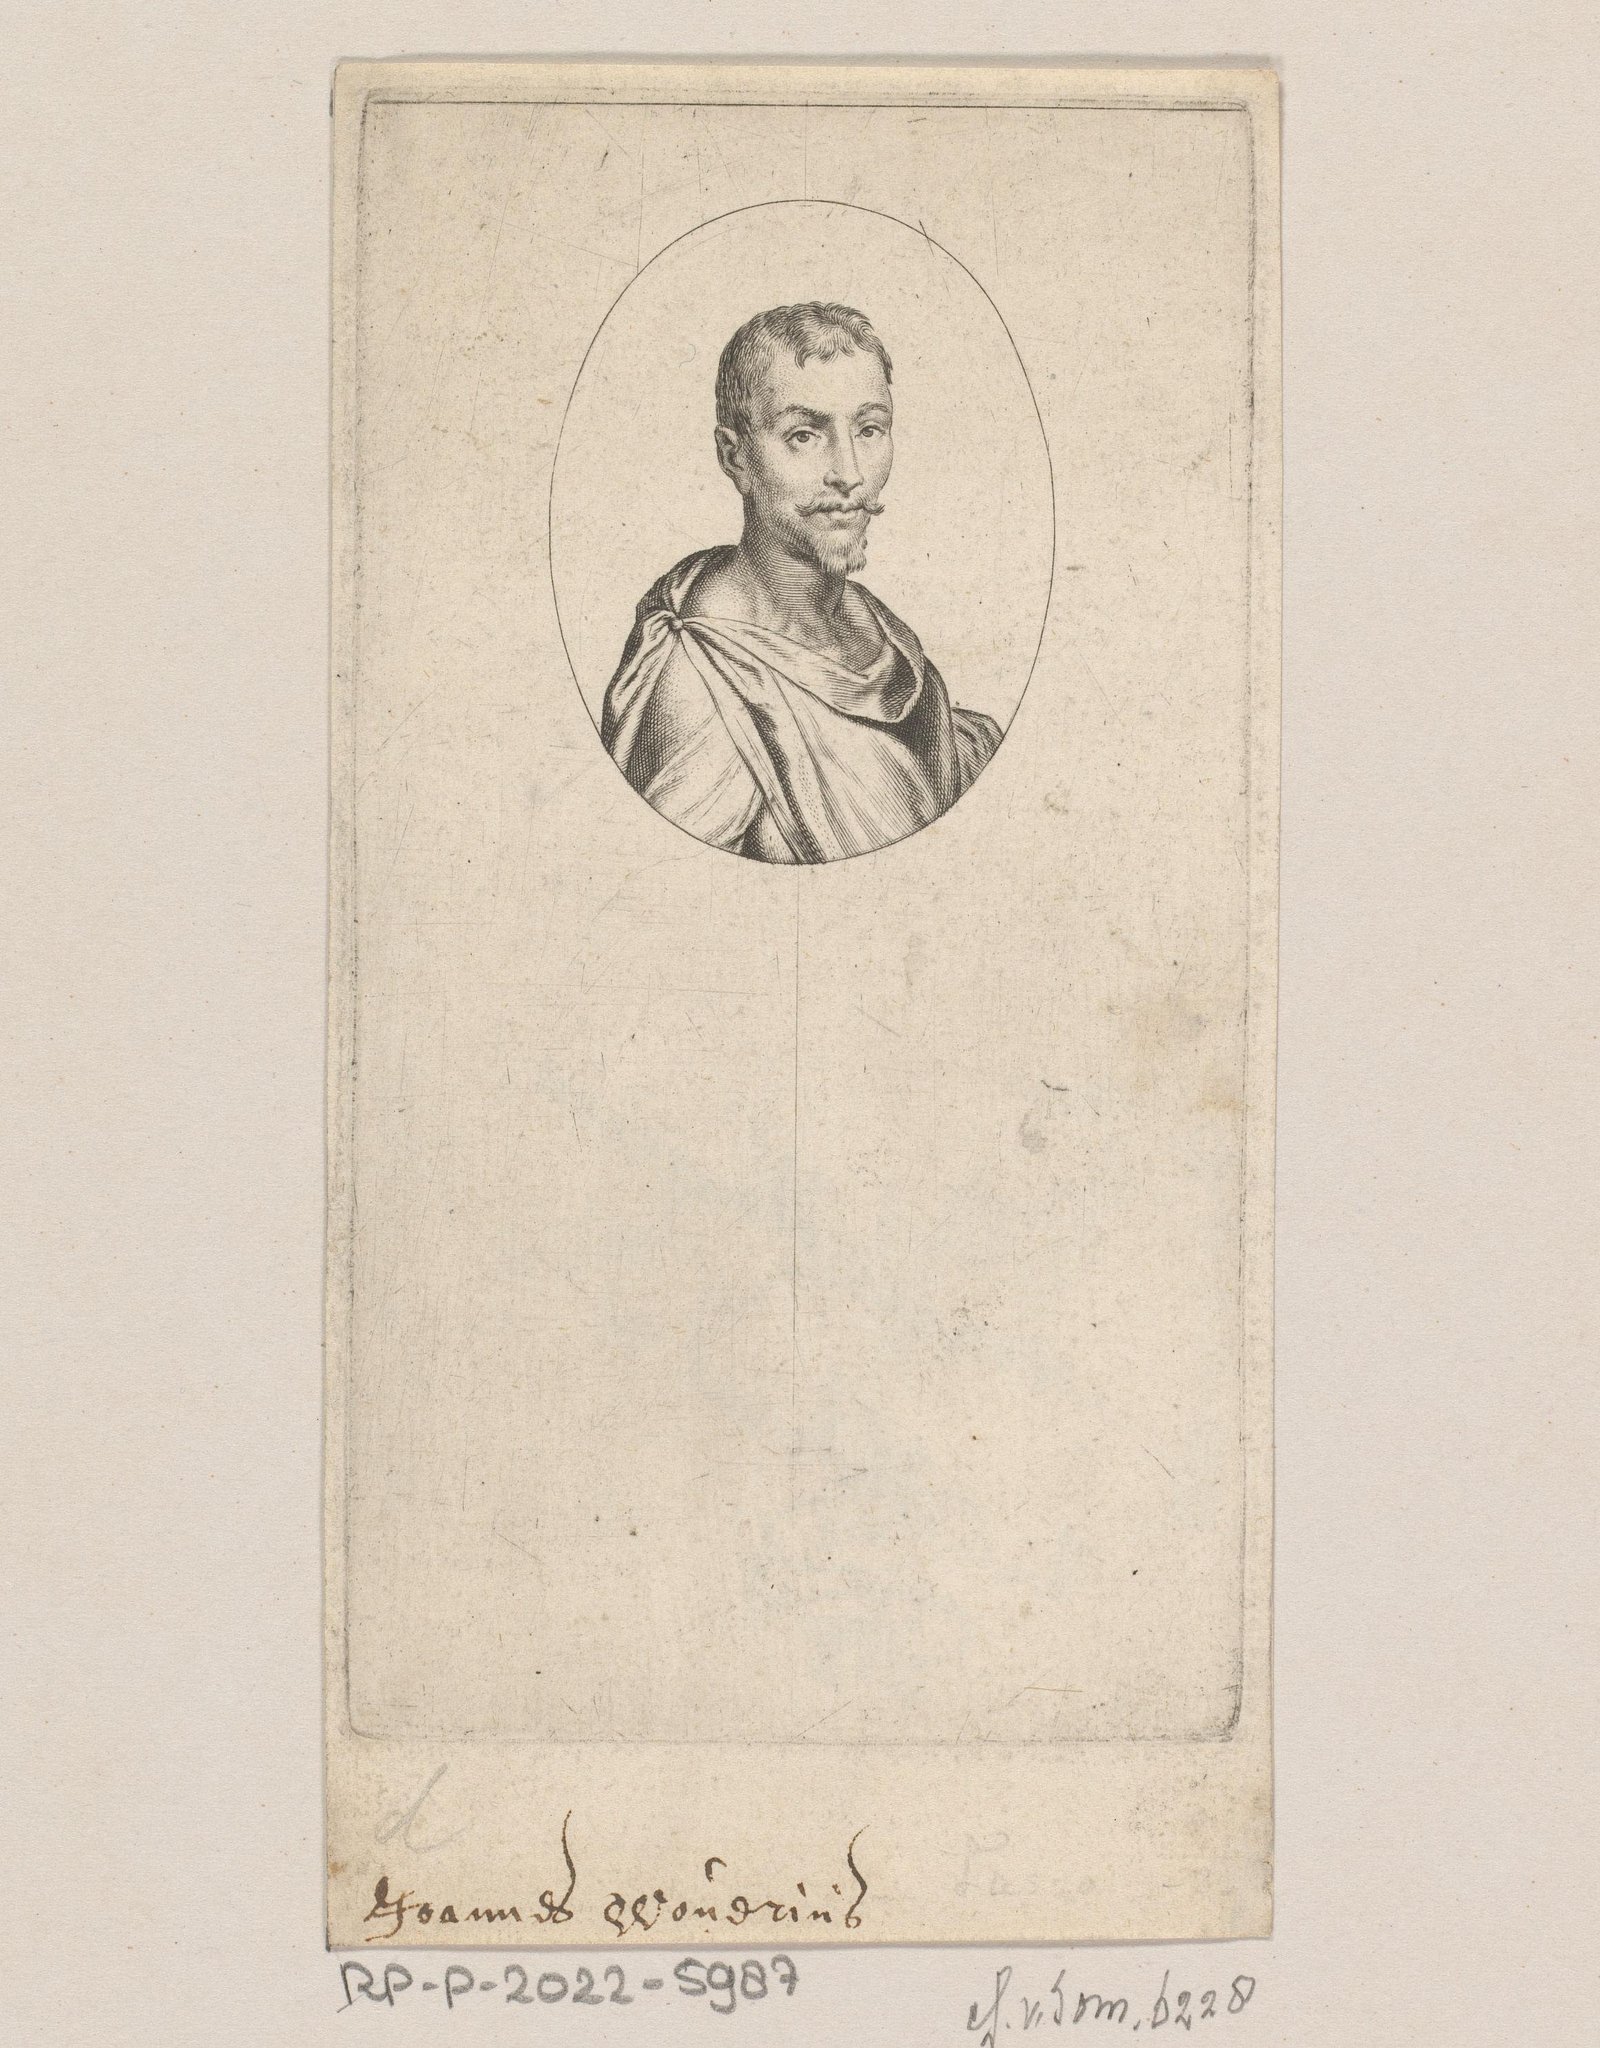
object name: print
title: Portret van Jan van den Wouwer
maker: Anonymous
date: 1600-1699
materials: paper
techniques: engraving, etching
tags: antwerp, brussels, jan van den wouwer, scholar, philosopher, historical persons, diplomacy, diplomat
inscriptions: inscription: ‘Joannes Woverius’, collector's mark: Lugt 2228